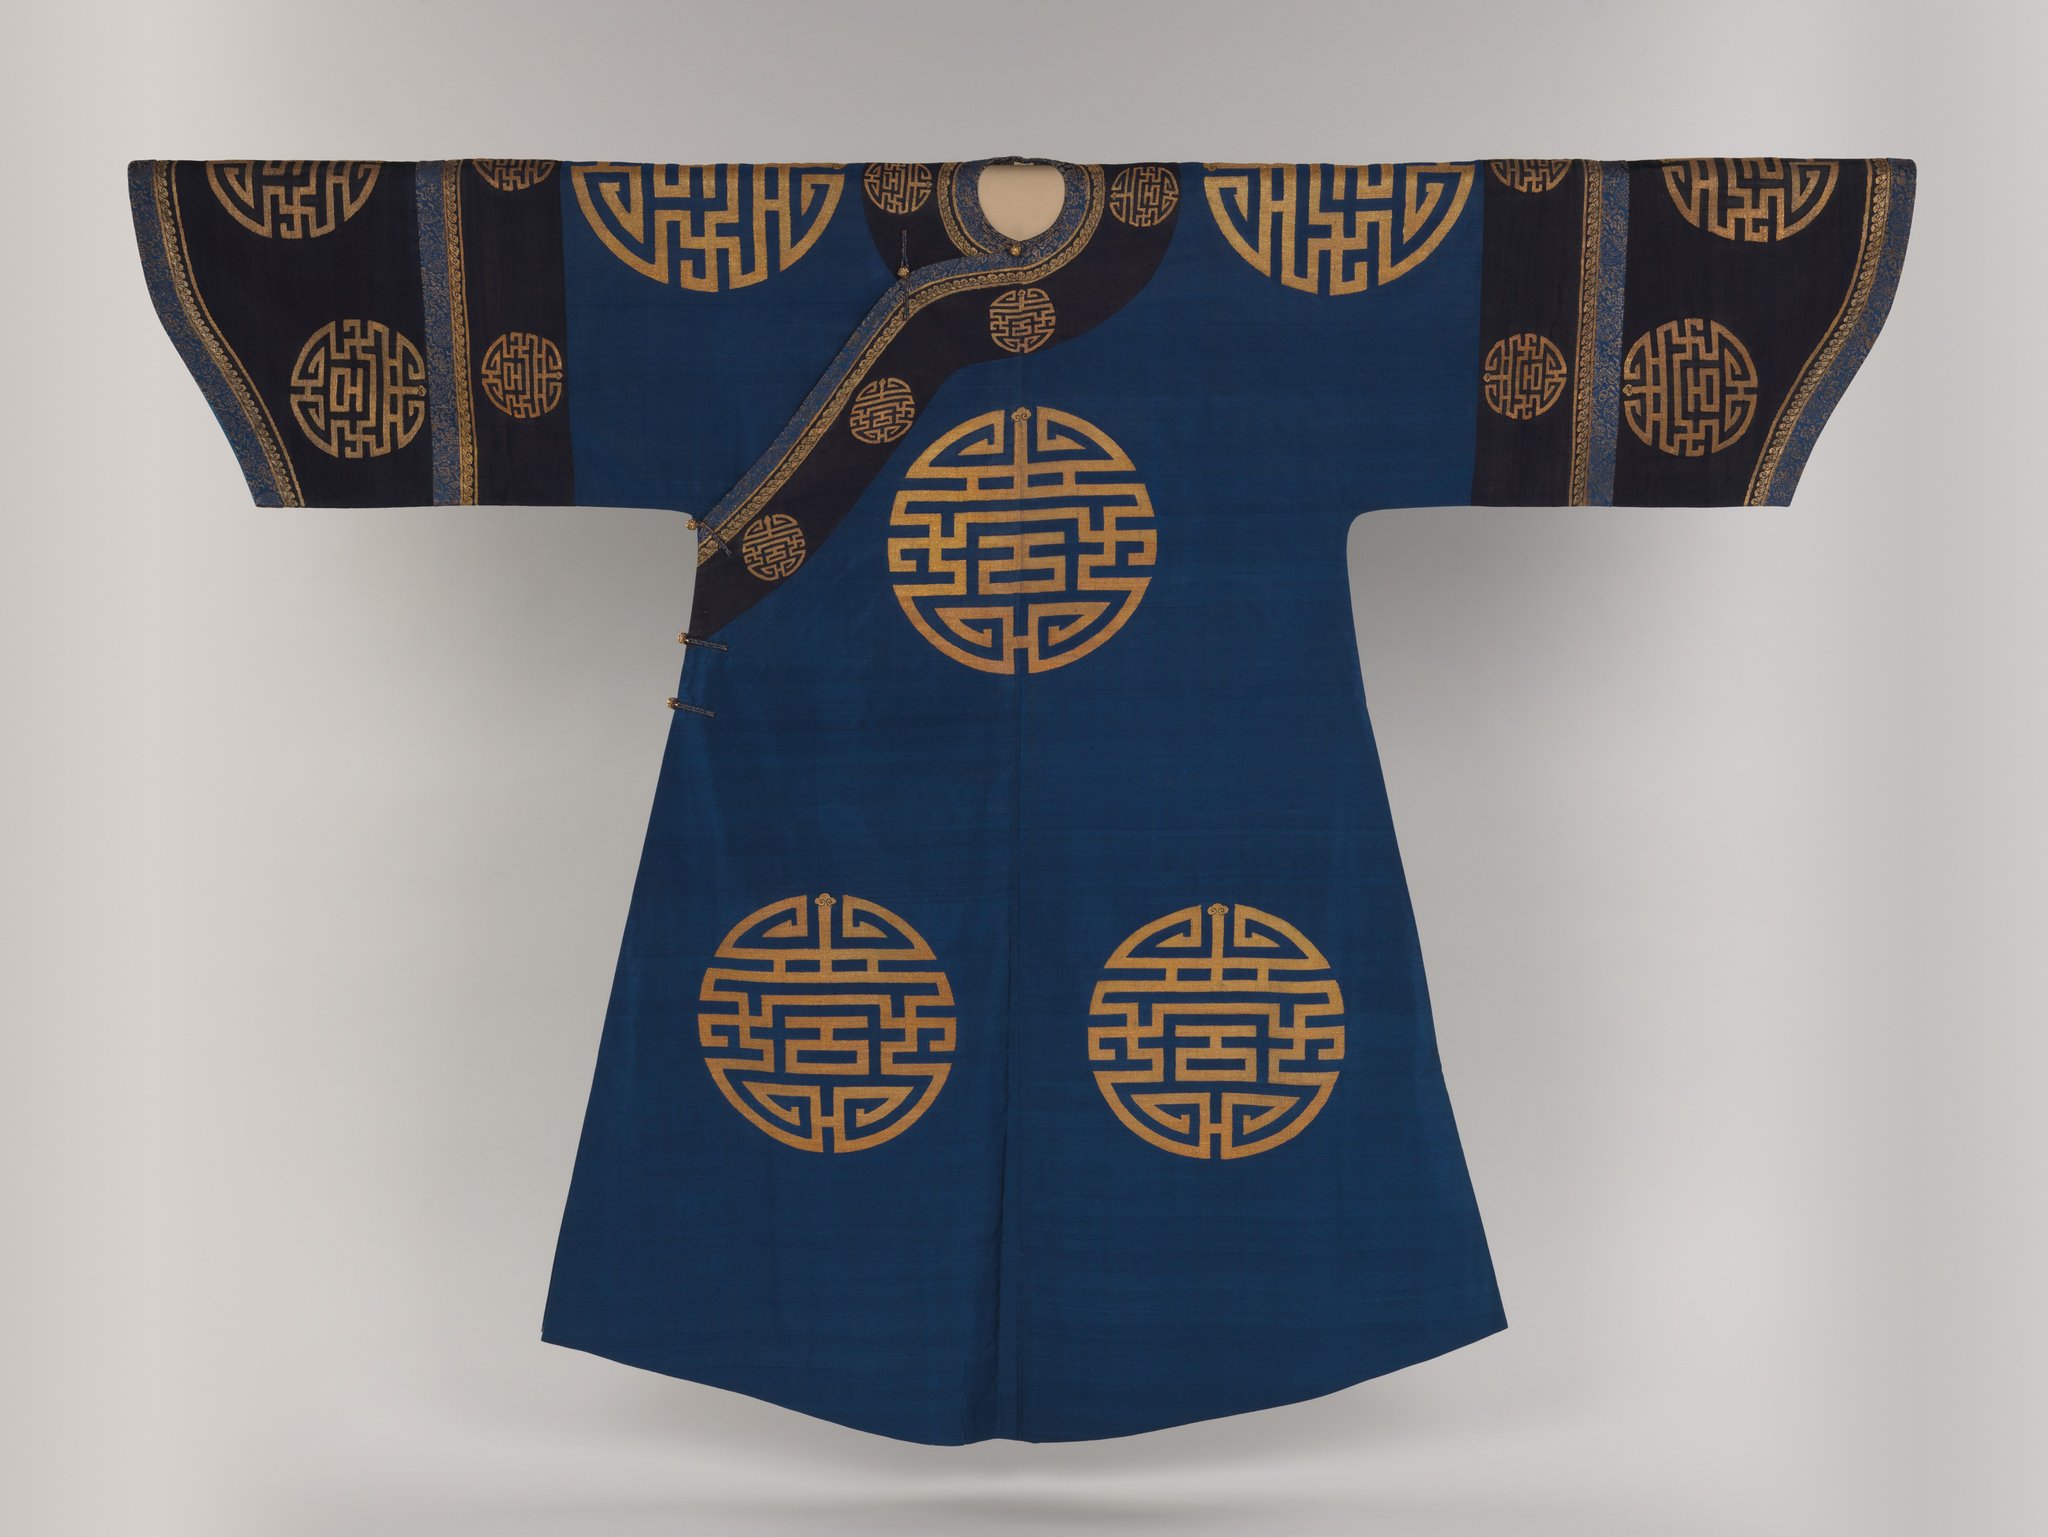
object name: robe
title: Woman's Robe with "Longevity" Medallions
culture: chinese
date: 1801-1900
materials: metal thread, silk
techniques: tapestry